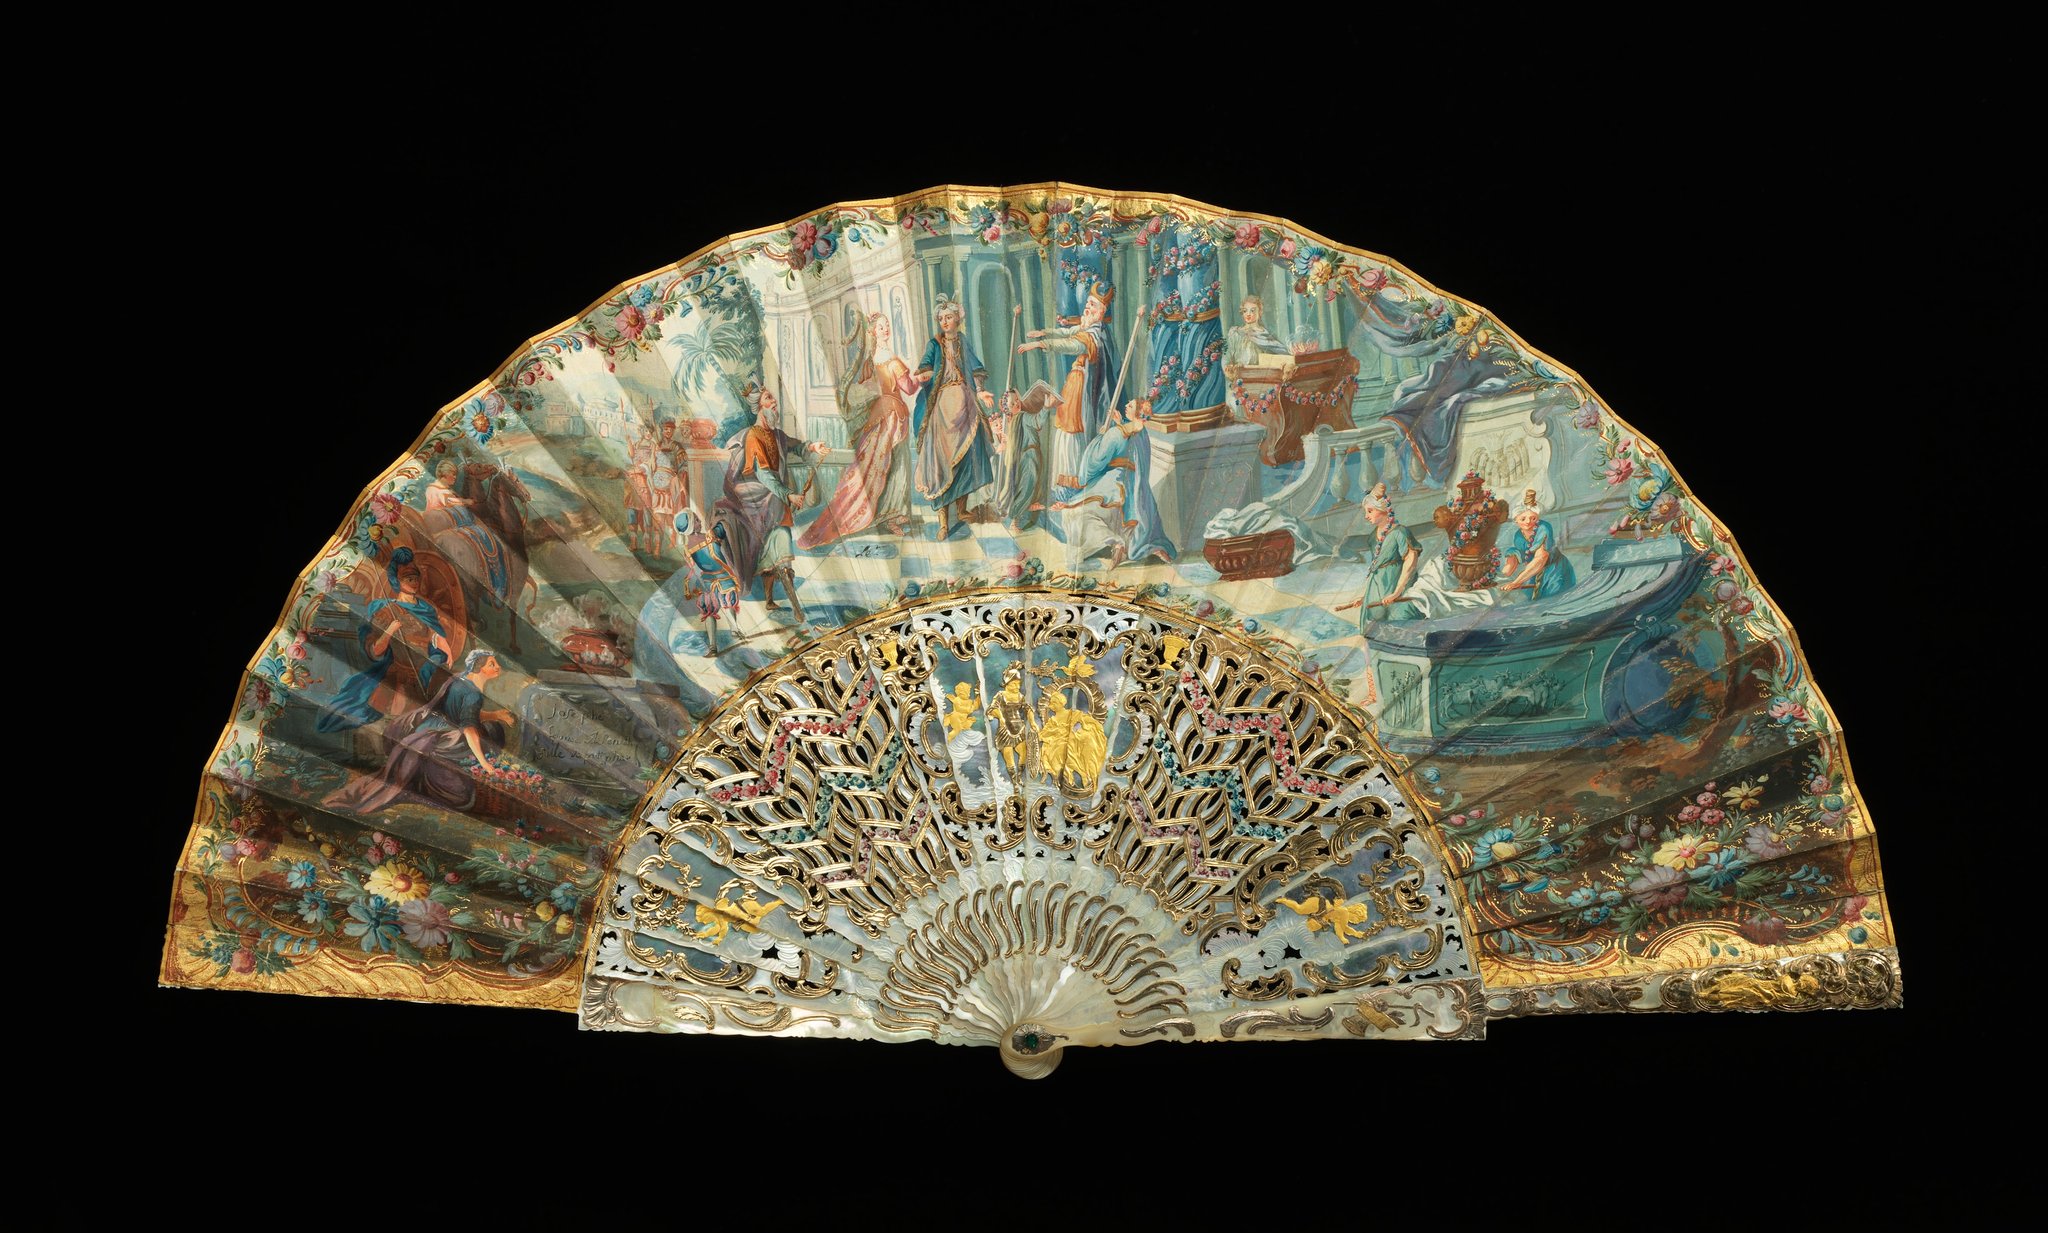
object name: fan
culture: french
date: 1860-1880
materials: gouache, metal, mother of pearl, paper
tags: men,women